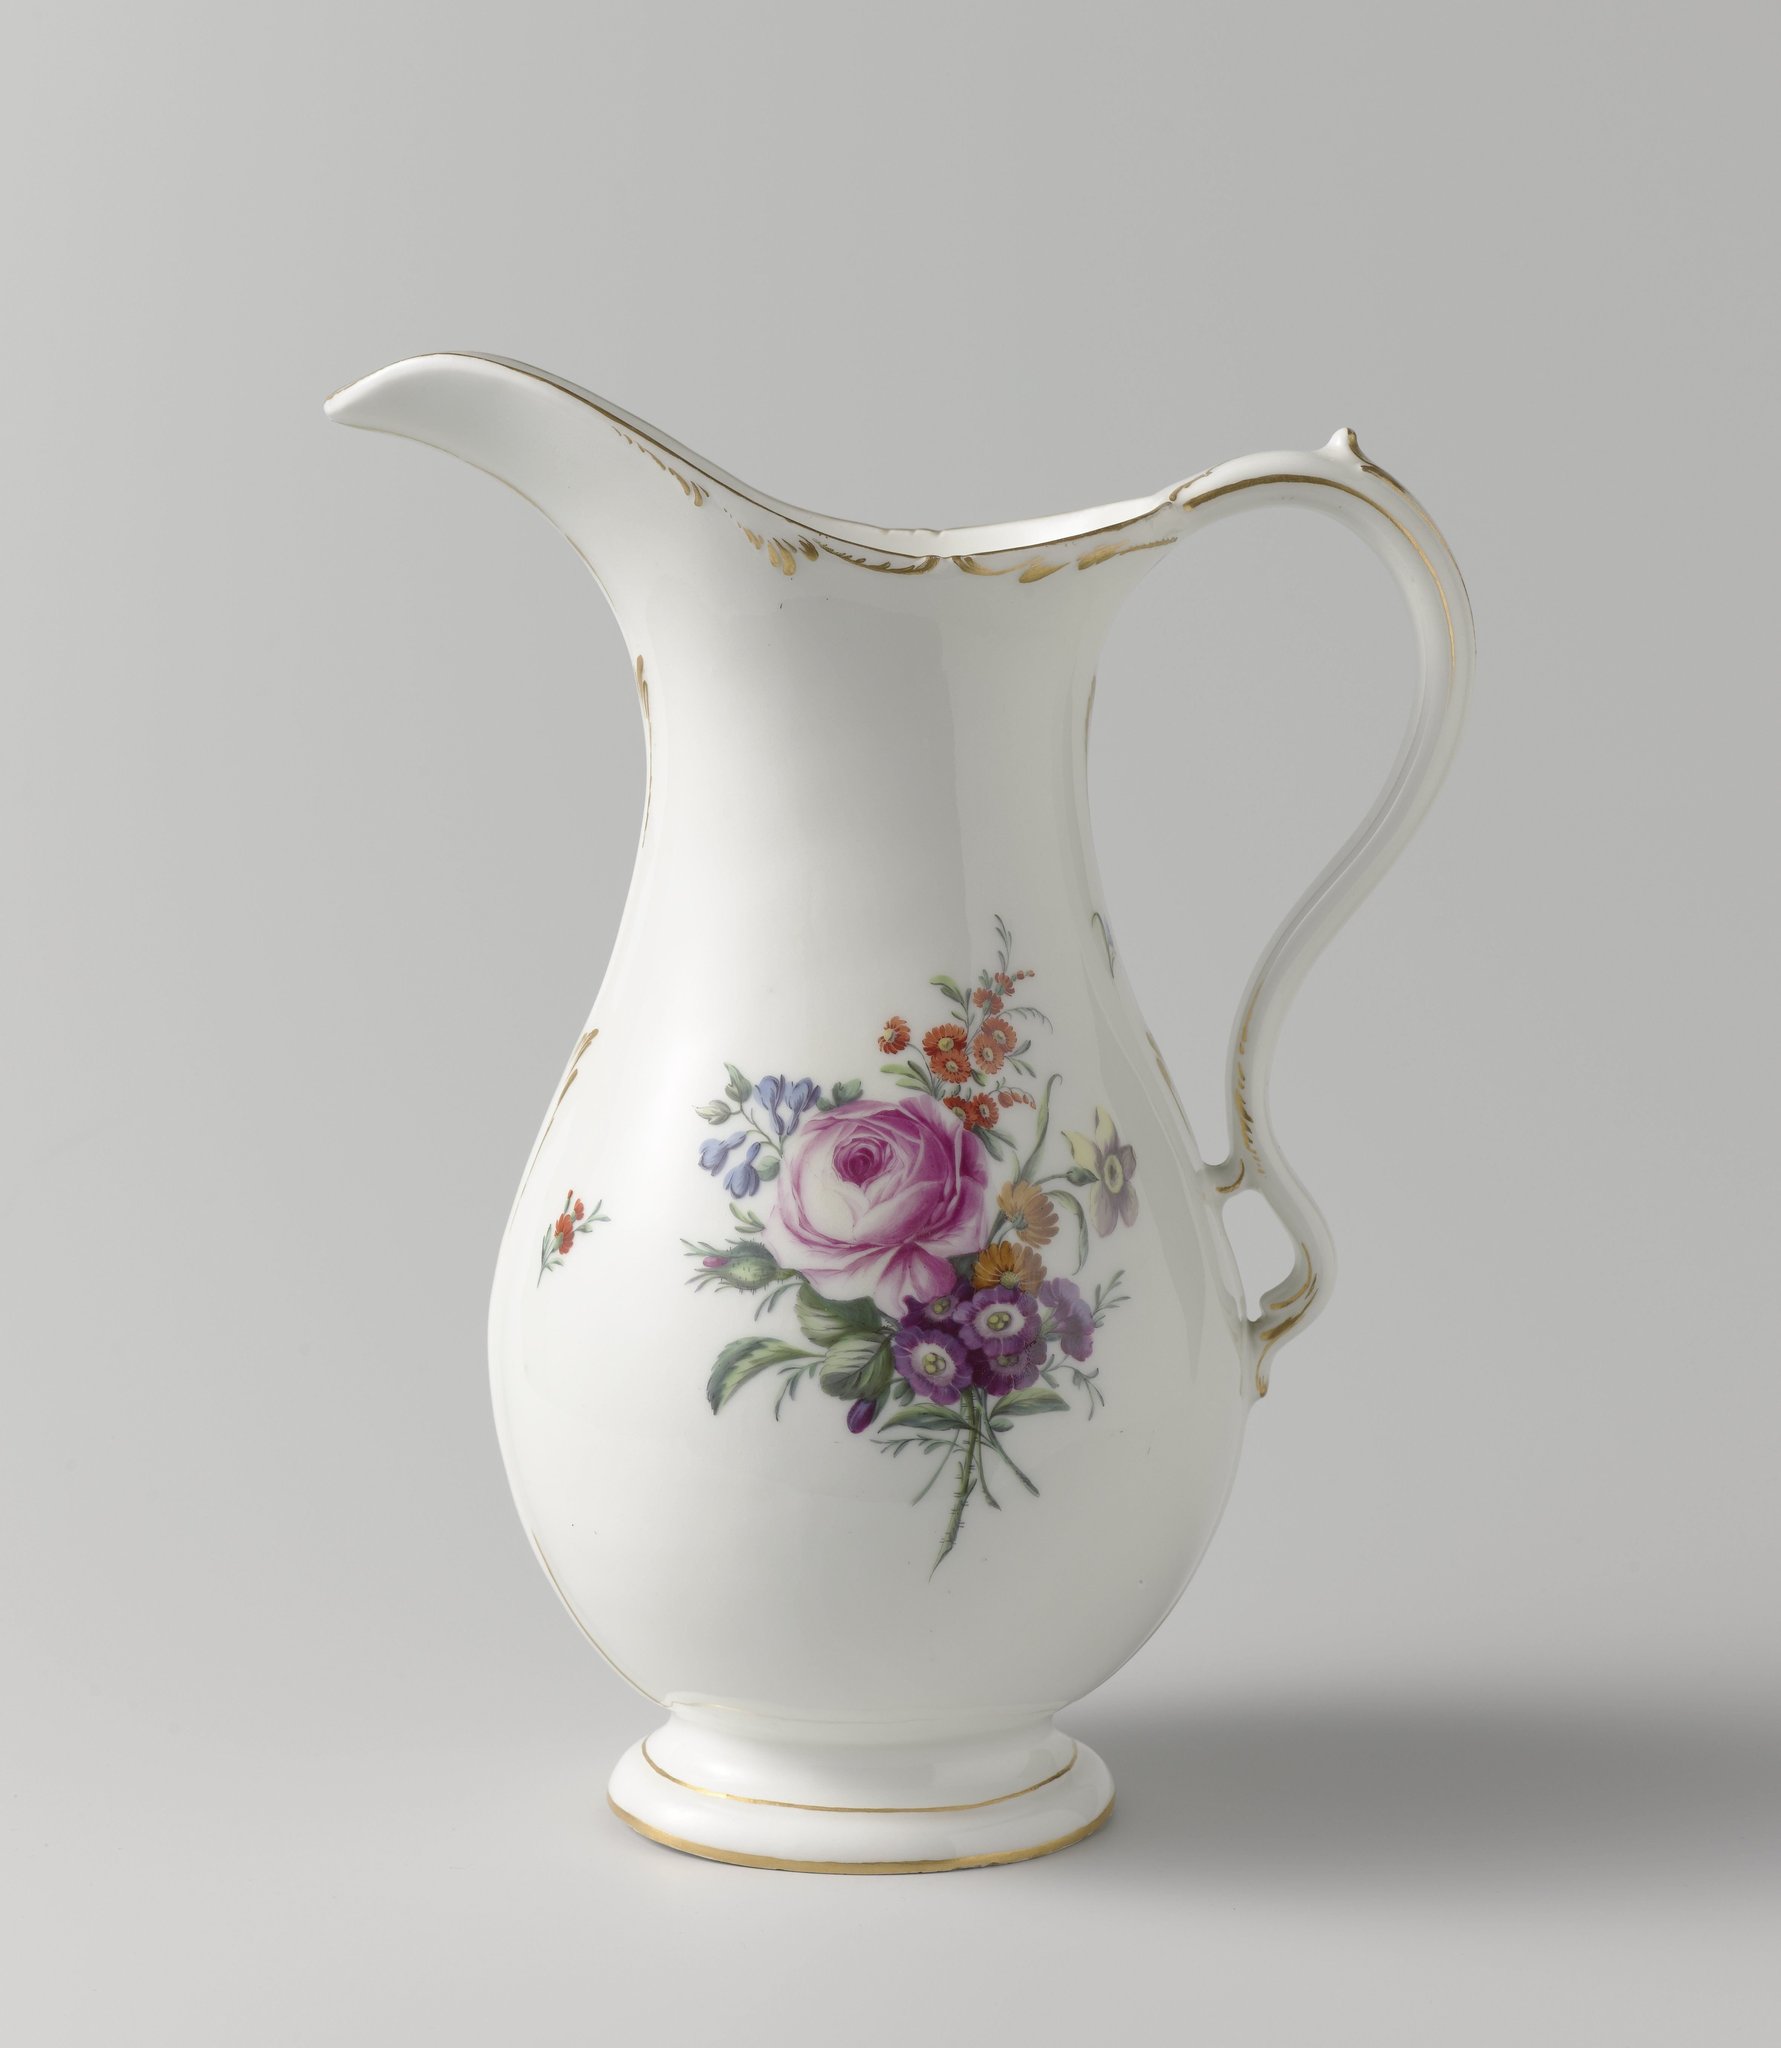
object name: ewer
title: Kan met twee bloemboeketten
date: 1774-1782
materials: porcelain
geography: loosdrecht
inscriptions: mark: ‘L 48’, mark: ‘MOL’, mark: ‘M.O.L.’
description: Ewer and basin. Porcelain. Loosdrecht, c. 1778 - 1782. Factory of Joannes de Mol.